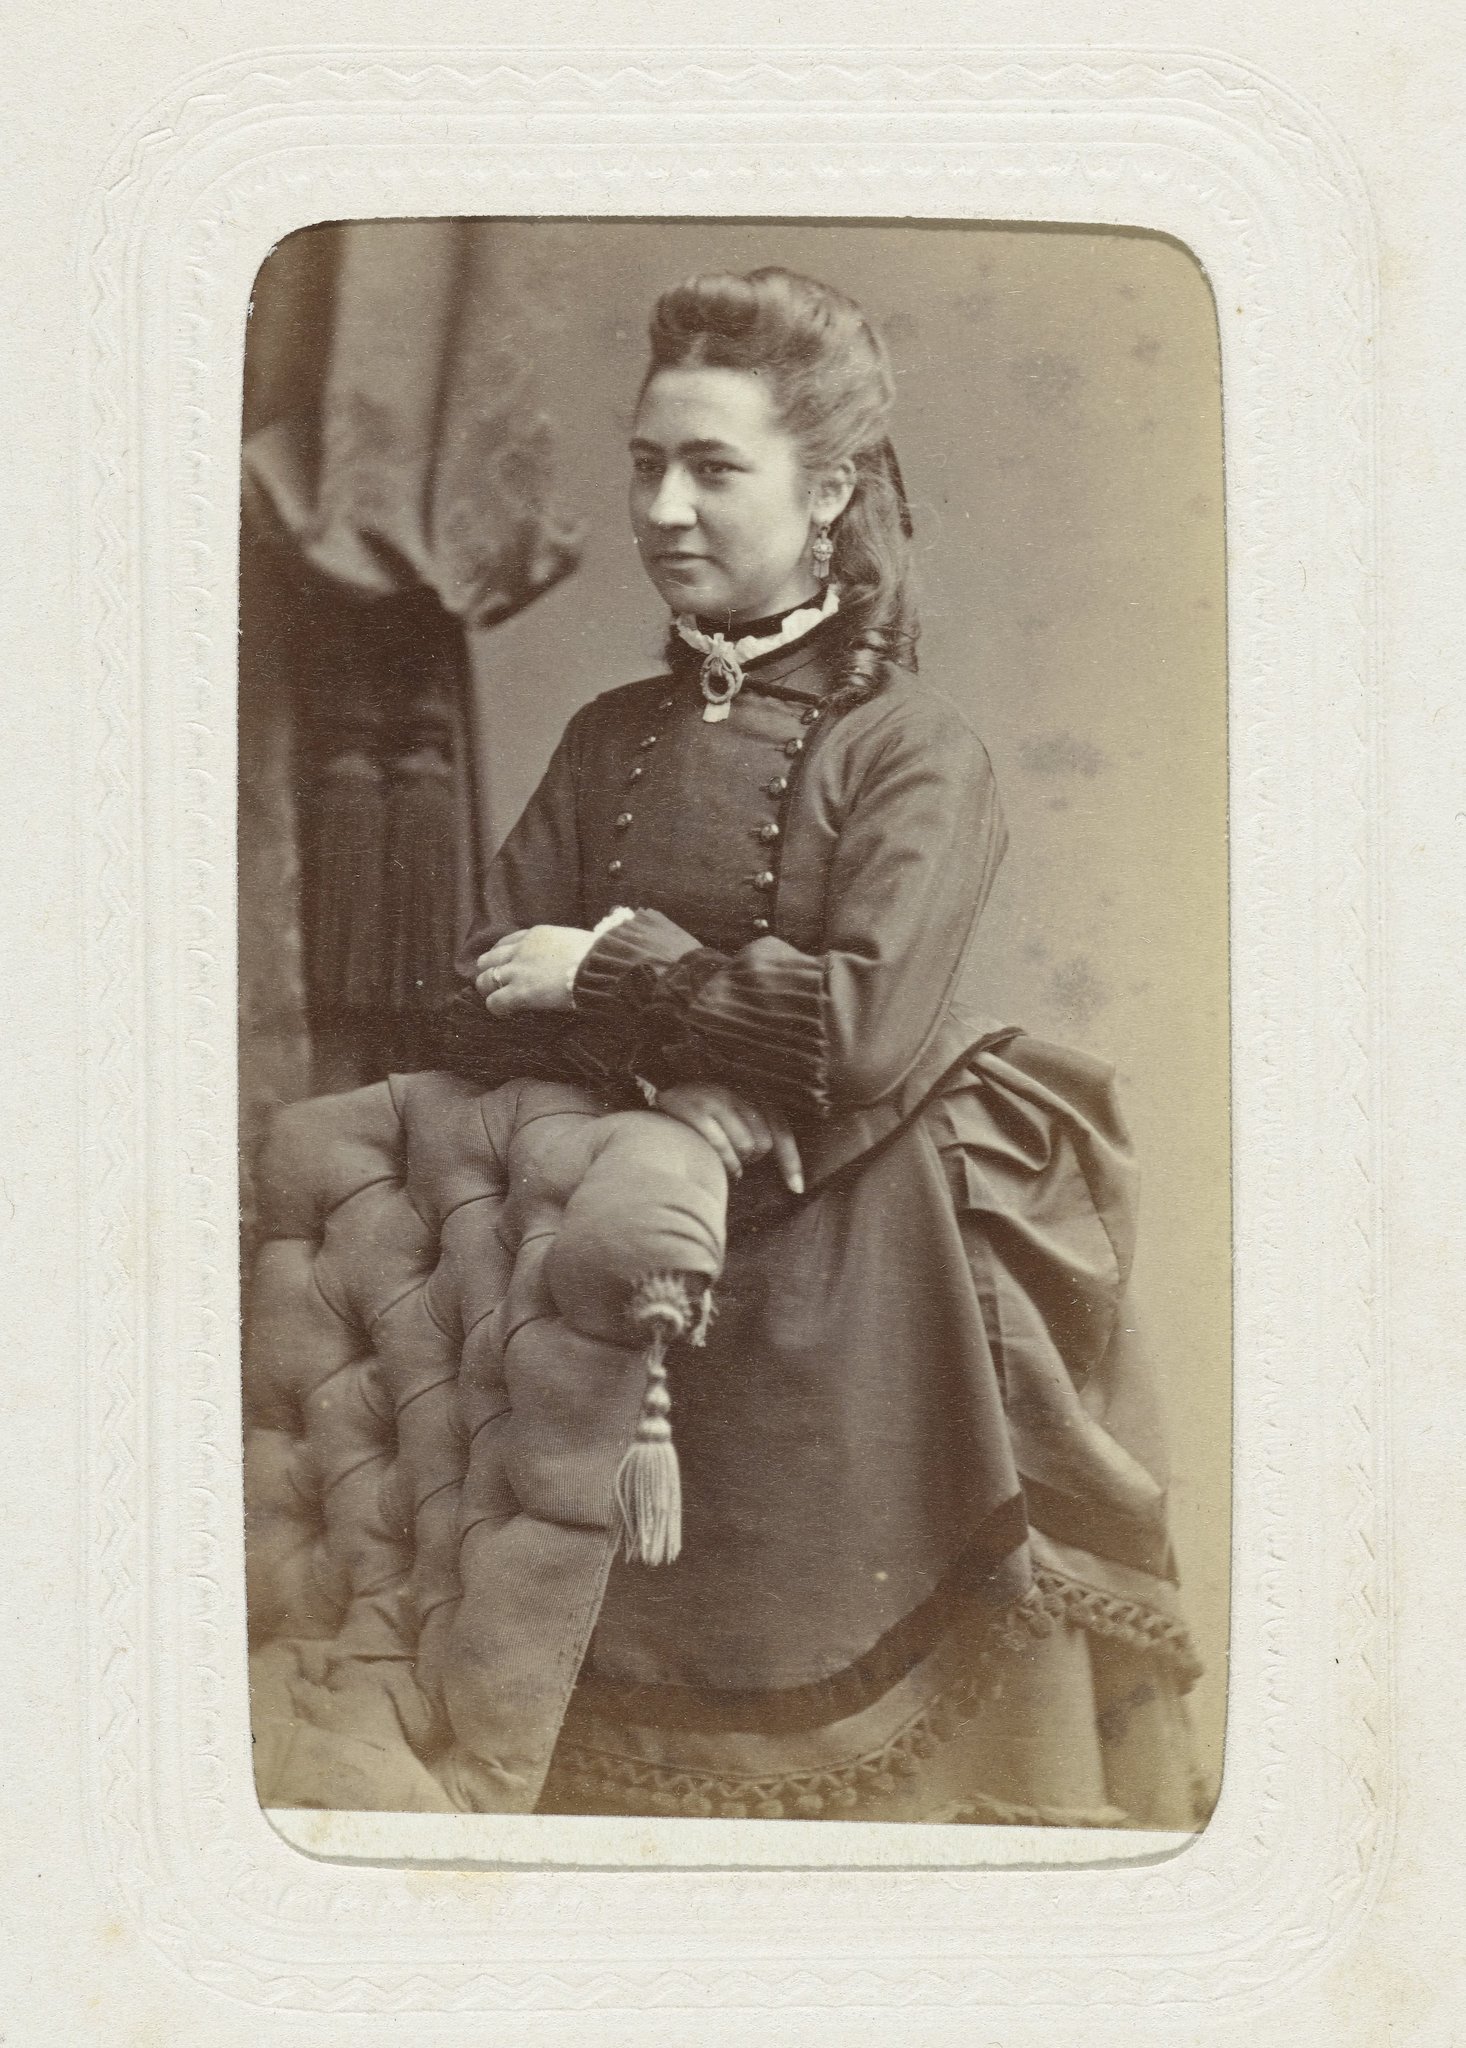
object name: carte de visite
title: Studioportret van een staande jonge vrouw in een zwarte jurk naast een stoelleuning.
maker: albert greiner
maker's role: fotograaf, fotostudio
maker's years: 1833-1890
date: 1863-1866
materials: cardboard, paper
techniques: albumen print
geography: amsterdam